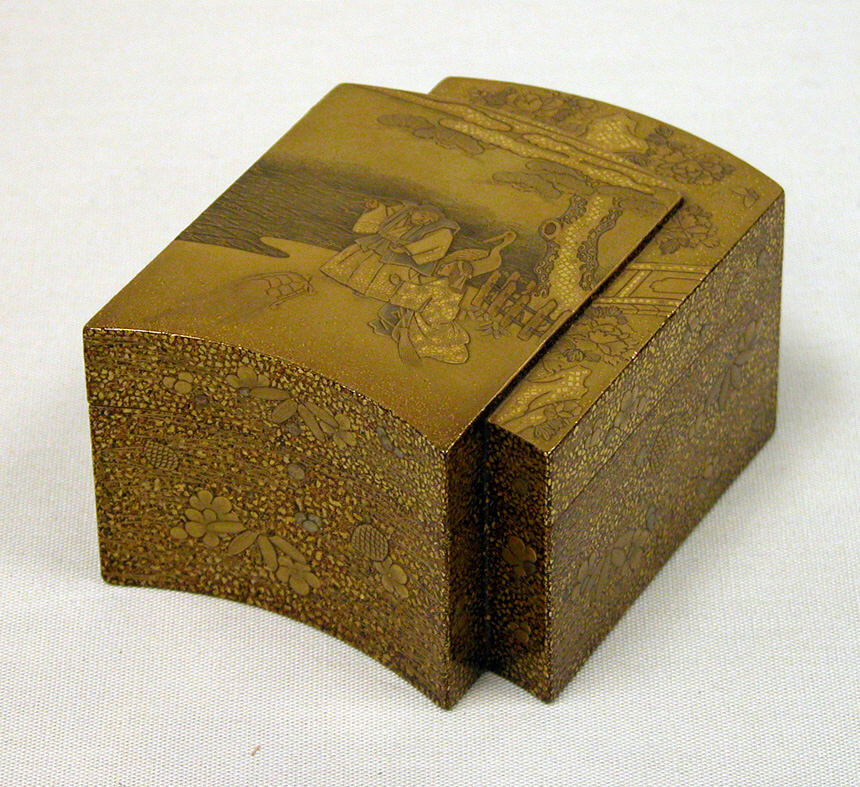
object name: incense box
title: Incense Box in the Shape of a Book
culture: japanese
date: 1801-1833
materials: gold, ivory, lacquer, metal, shell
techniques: inlay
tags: birds,men,trees